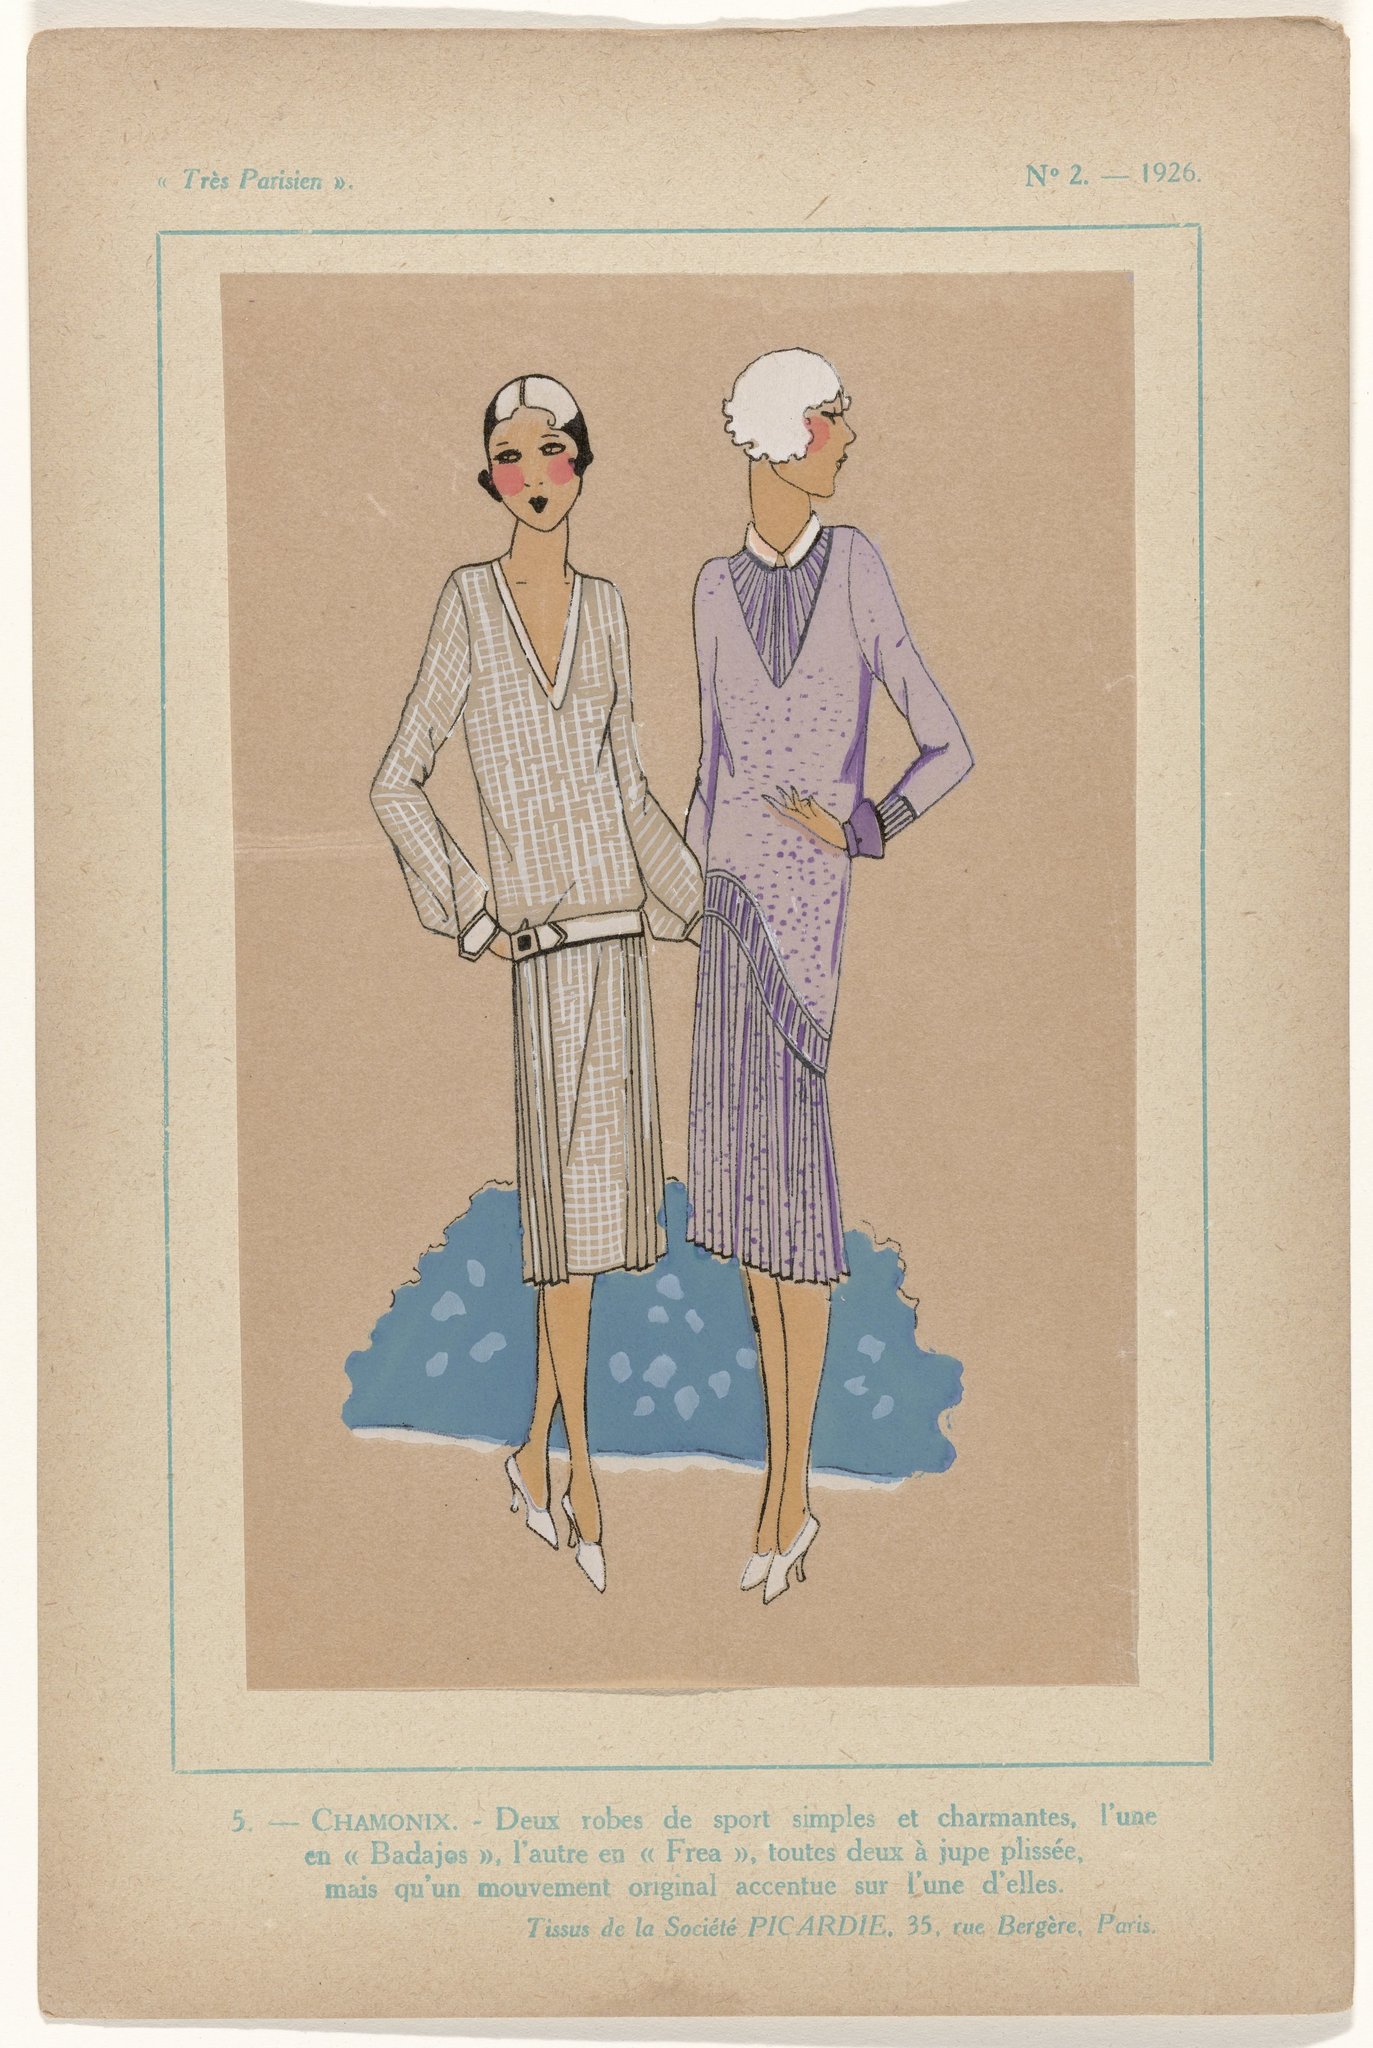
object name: fashion print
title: Très Parisien, 1926, No. 2, Pl. 5:- CHAMONIX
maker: g-p. joumard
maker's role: publisher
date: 1926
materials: paper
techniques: hand coloring, letterpress printing, lithography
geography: paris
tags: dress, gown (robe de sport) (+ women's clothes), fashion plates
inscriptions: caption: ‘Deux robes de sport simples et charmantes, l'une en "Badajos" l'autre en "Frea" , toutes deux en jupe plissée, mais qu'un mouvement original accentue sur l'une d'elles.’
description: Twee 'robes de sport": een voudige sportieve jurken. Stoffen van PICARDIE. Prent uit het modetijdschrift Très Parisien... La Mode, Le Chic, L'Élegance (1920-1936)